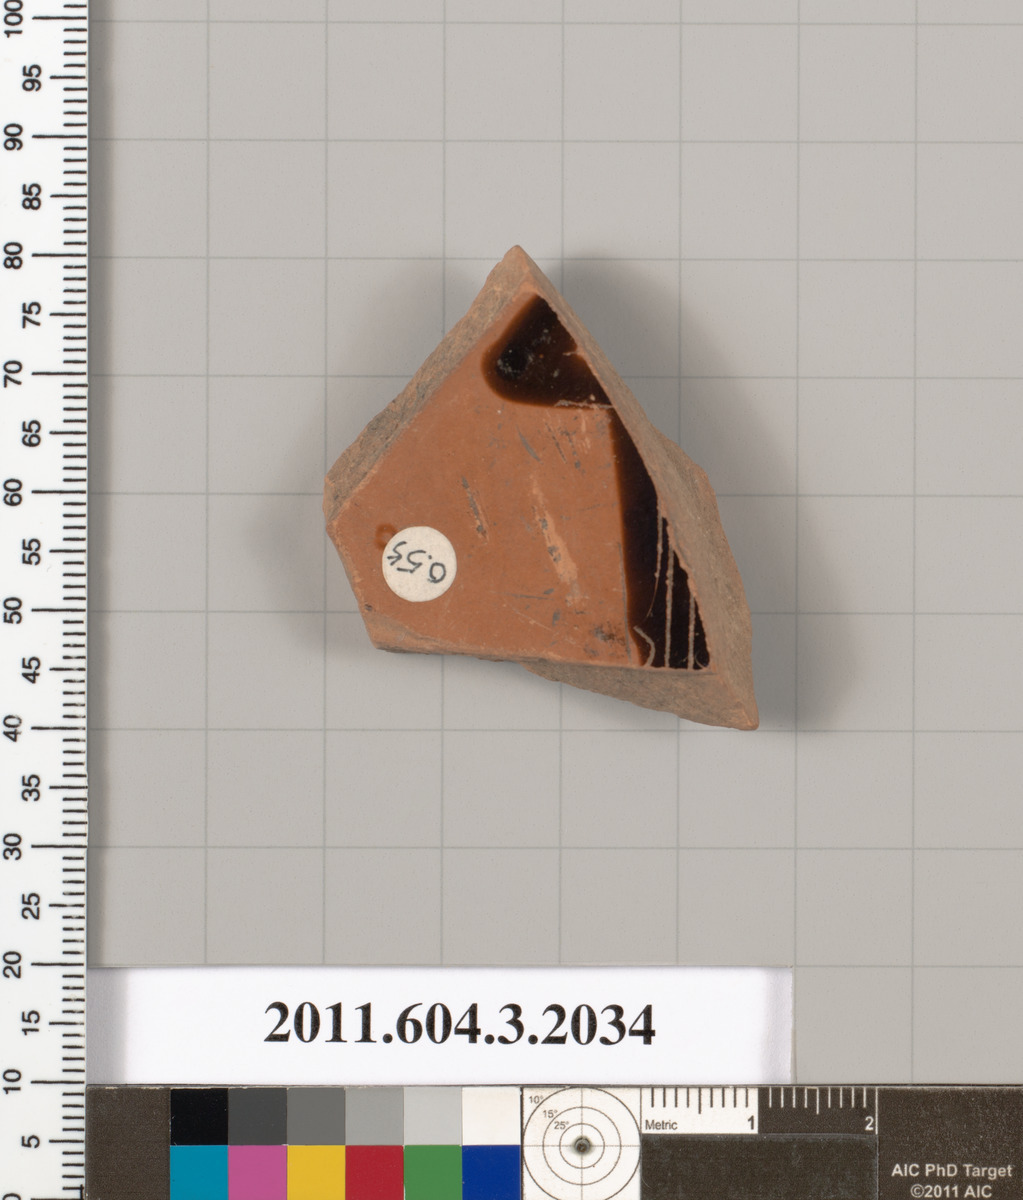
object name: kylix fragment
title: Terracotta fragment of a kylix (drinking cup)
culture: greek, attic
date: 500-468 BCE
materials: terracotta